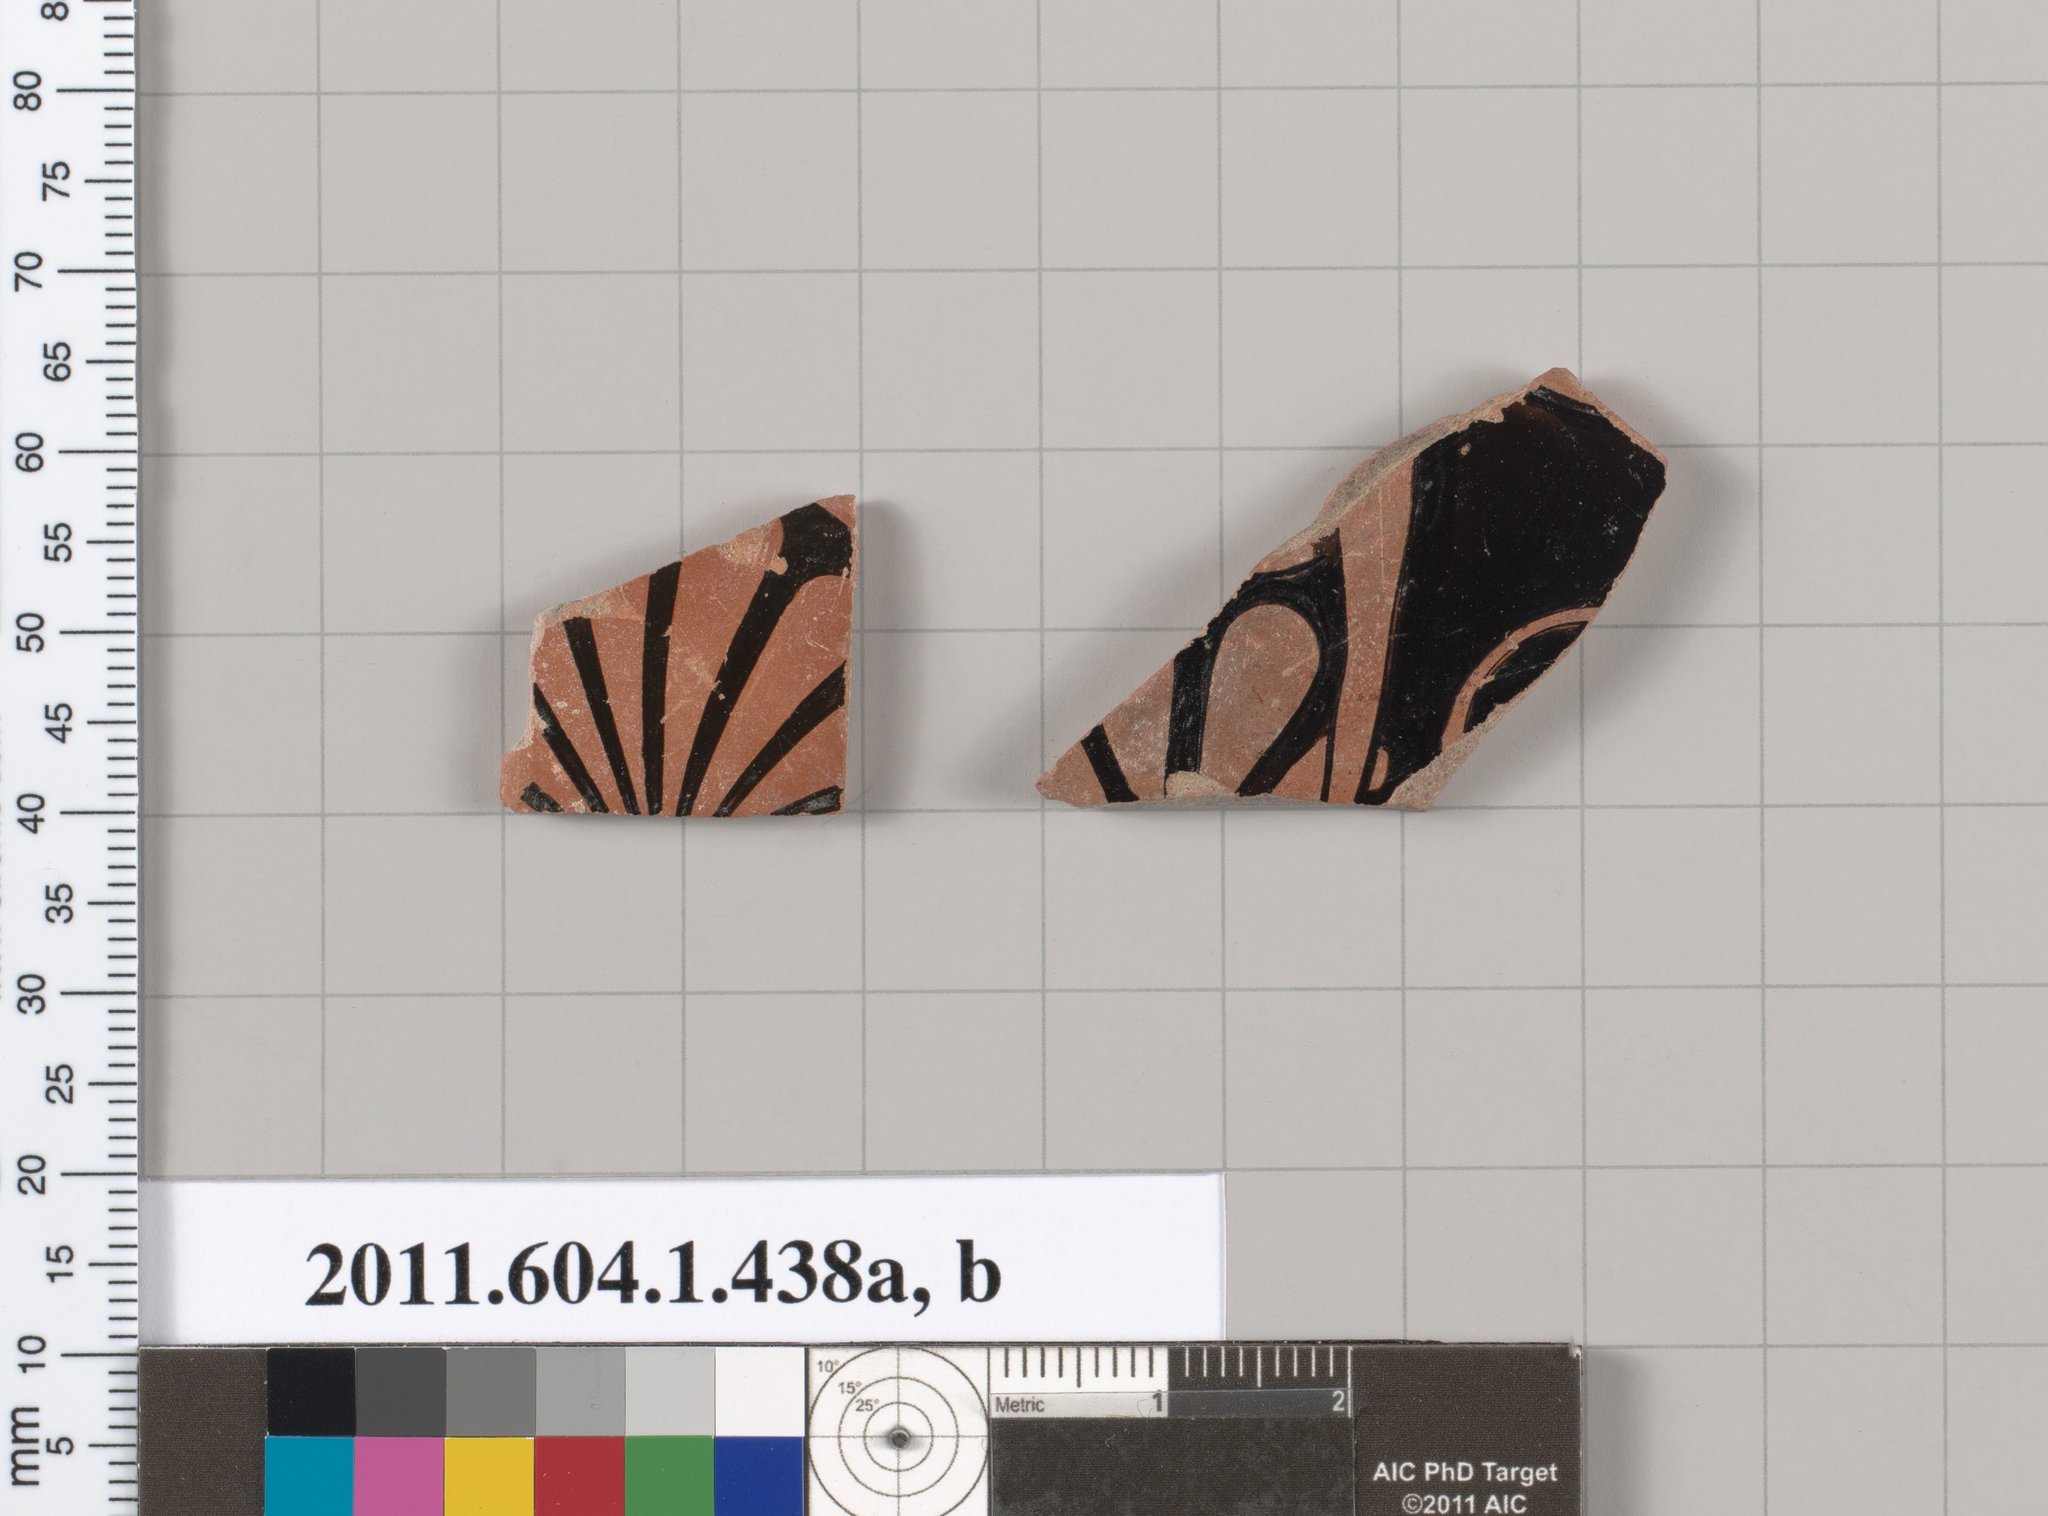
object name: kylix fragment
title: Terracotta fragments of a kylikes (drinking cups)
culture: greek, attic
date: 475-451 BCE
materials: terracotta